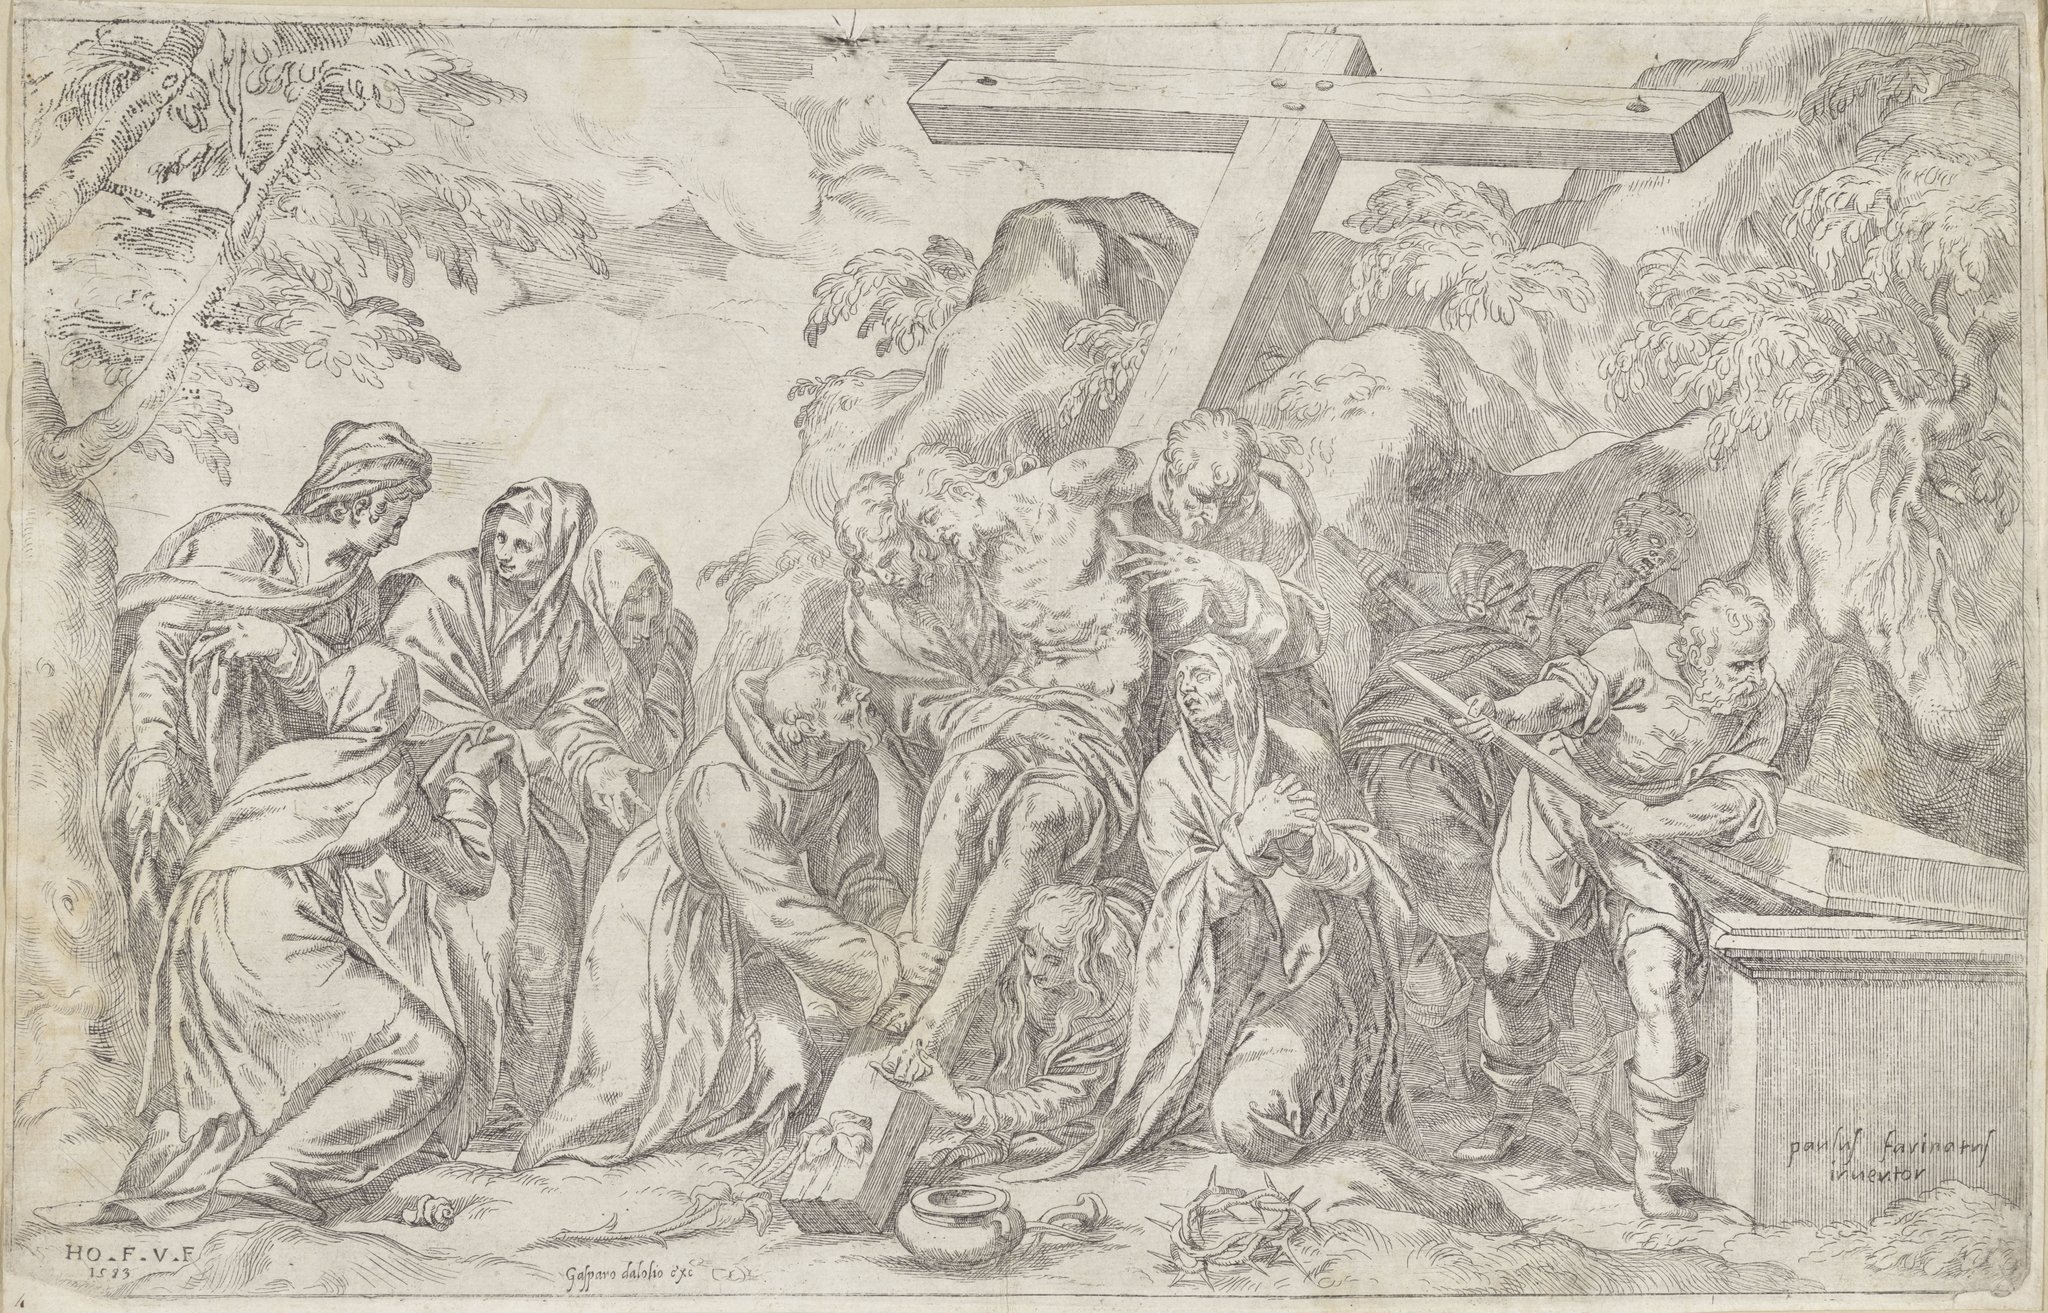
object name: print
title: Kruisafneming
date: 1583-1593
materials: paper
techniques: etching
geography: italy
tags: descent from the cross: christ is taken down from the cross, usually by nicodemus and joseph of arimathaea who are standing on the ladders (both arms of christ detached)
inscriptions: number: ‘4’, collector's mark: Lugt 10, collector's mark: Lugt 11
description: Het lichaam van Christus wordt van het kruis gehaald door Johannes de Evangelist, Jozef van Arimatea en Nikodemus. Maria Magdalena knielt bij de voeten van Christus. Maria zit treurend naast het kruis geknield. Rechts drie mannen die het graf voor Christus openen. Links een groepje toeschouwers, mogelijk de Maria´s.